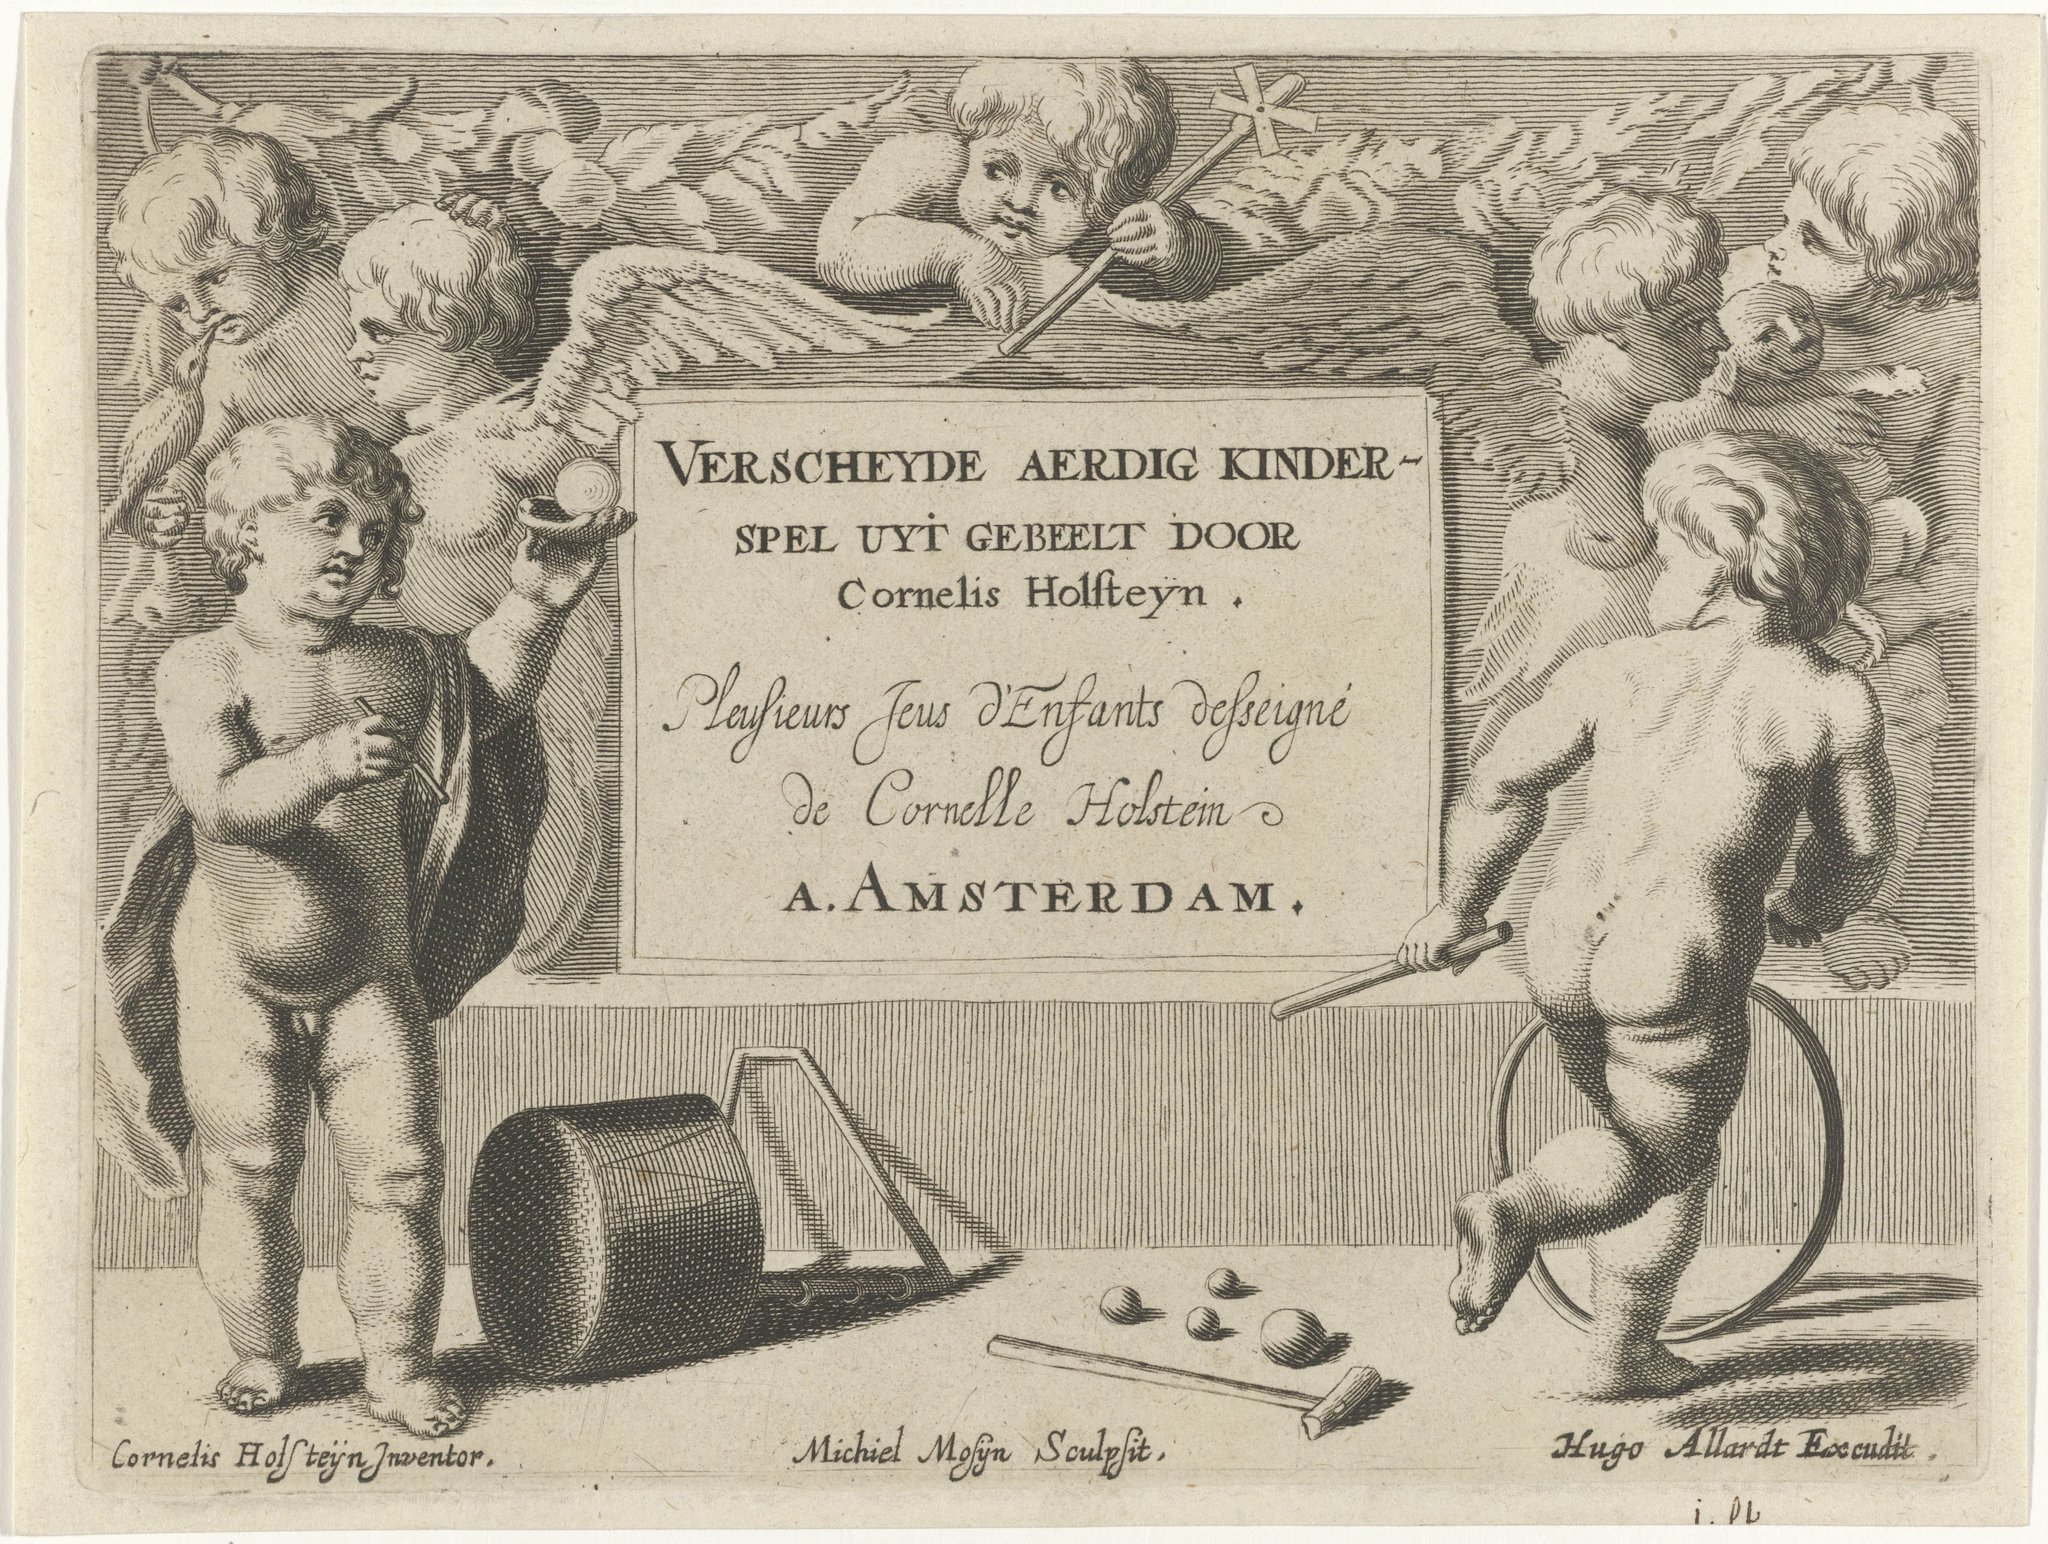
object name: titelprent, frontispice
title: Kind met een bal en een kind met een hoepel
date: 1640-1655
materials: paper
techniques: engraving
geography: amsterdam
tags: children's games and plays, (bowling a) hoop, cupids: 'amores', 'amoretti', 'putti'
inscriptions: collector's mark: Lugt 2228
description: Een kind houdt een schelp in zijn hand, daarop ligt een bal. Een ander kind rent achter een hoepel aan. Op de achtergrond putti.